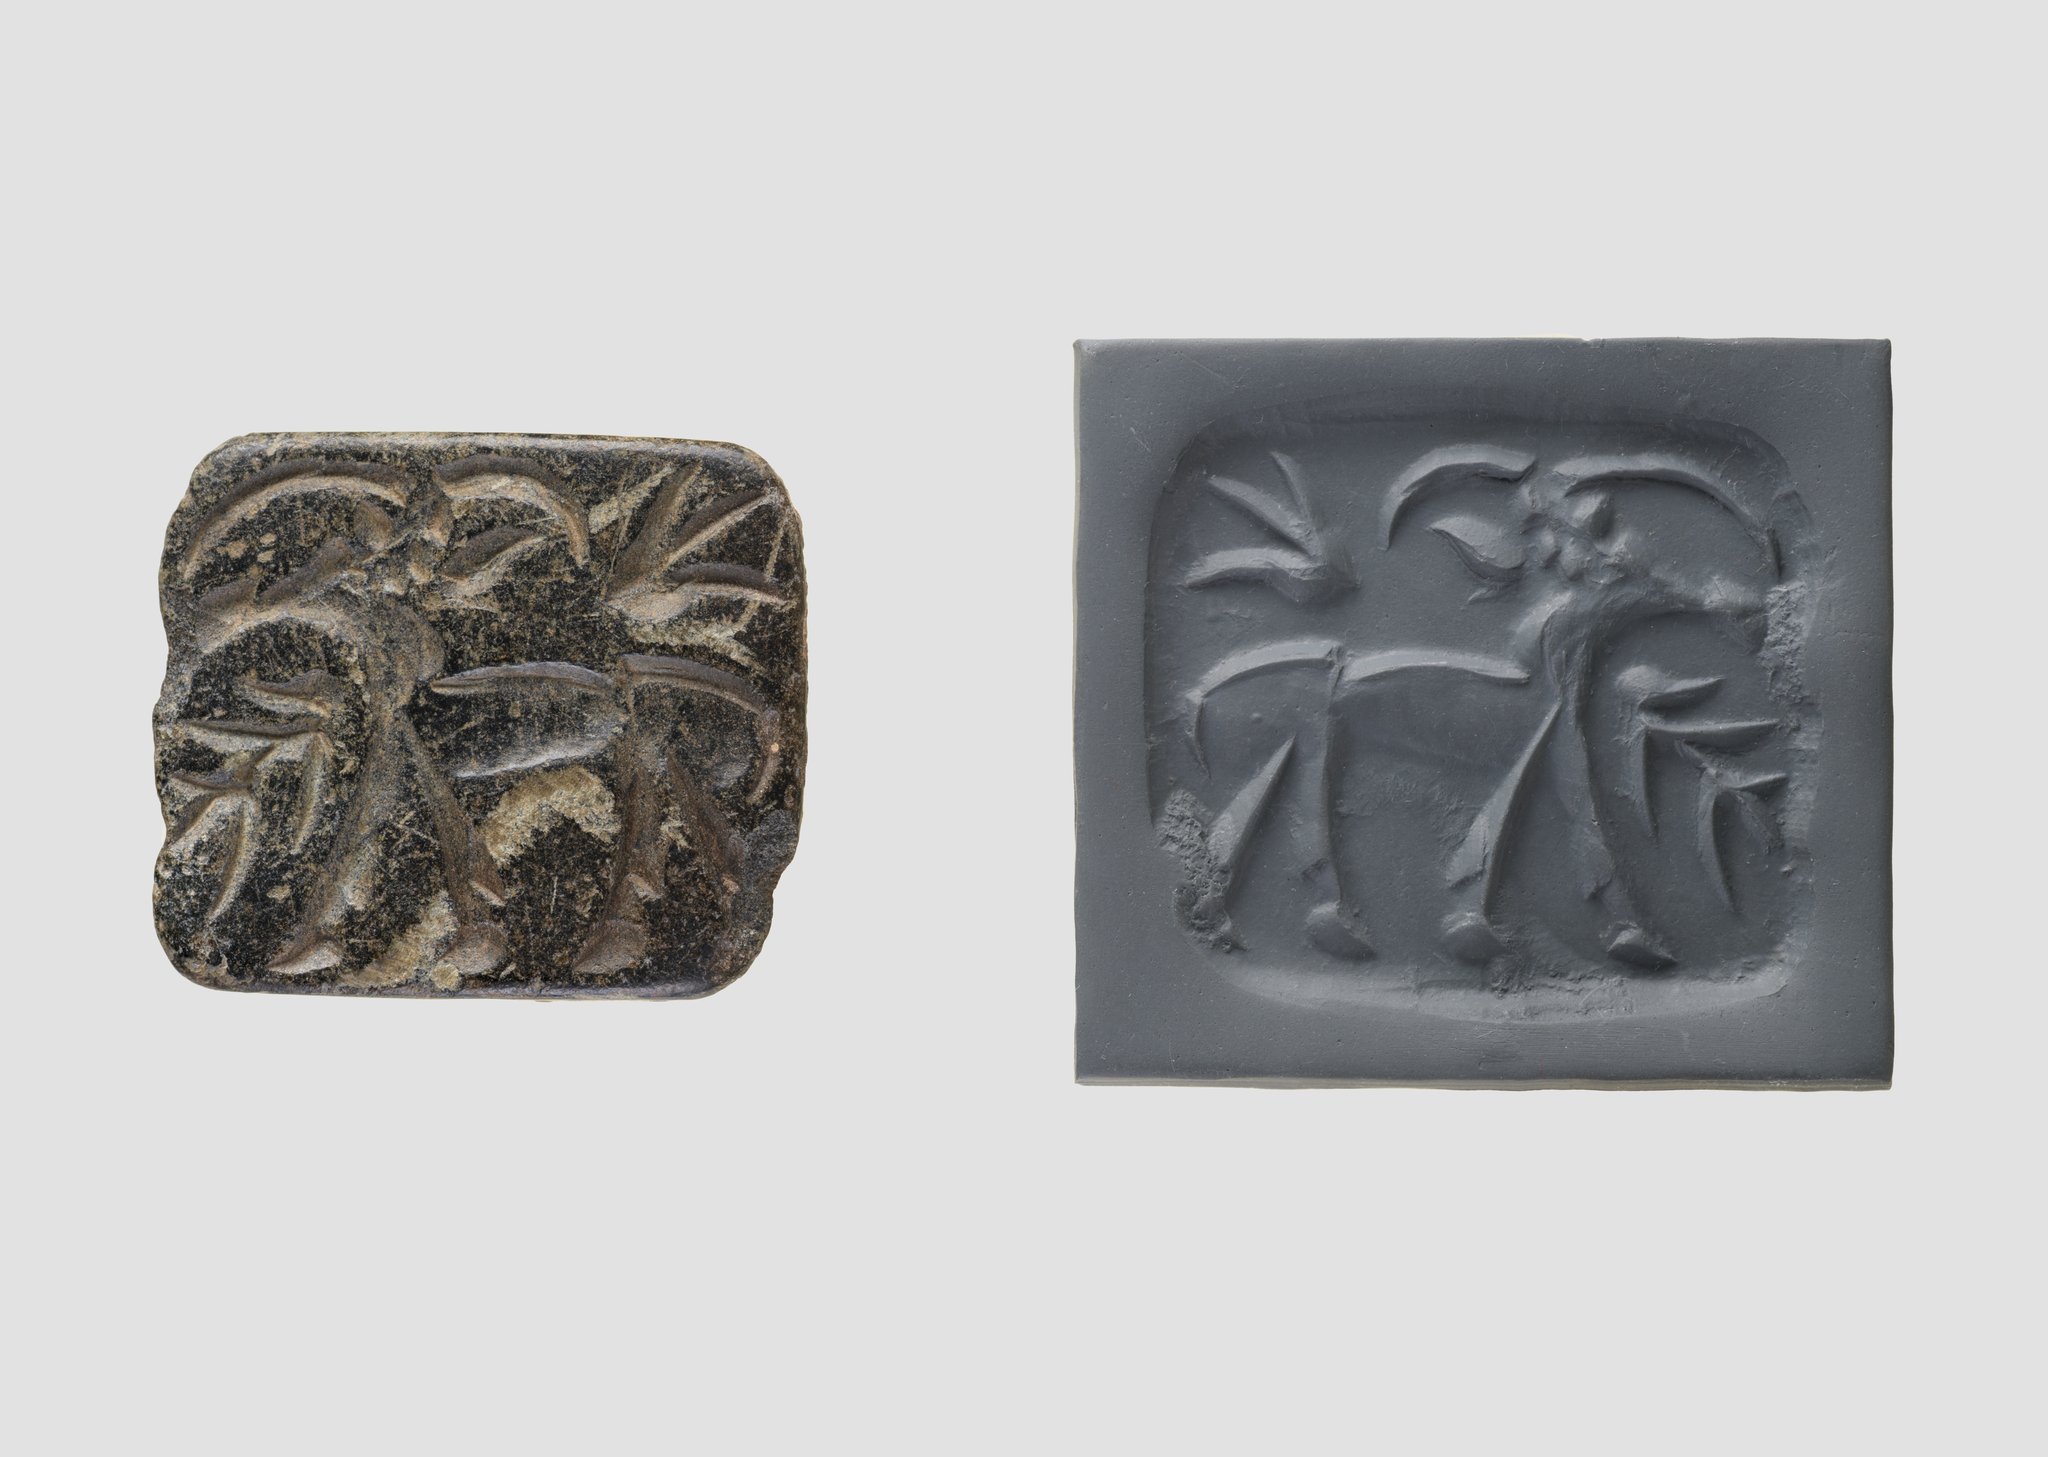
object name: stamp seal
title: Gable seal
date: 4000-3000 BCE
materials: mineral, stone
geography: northern syria or southeastern anatolia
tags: animals